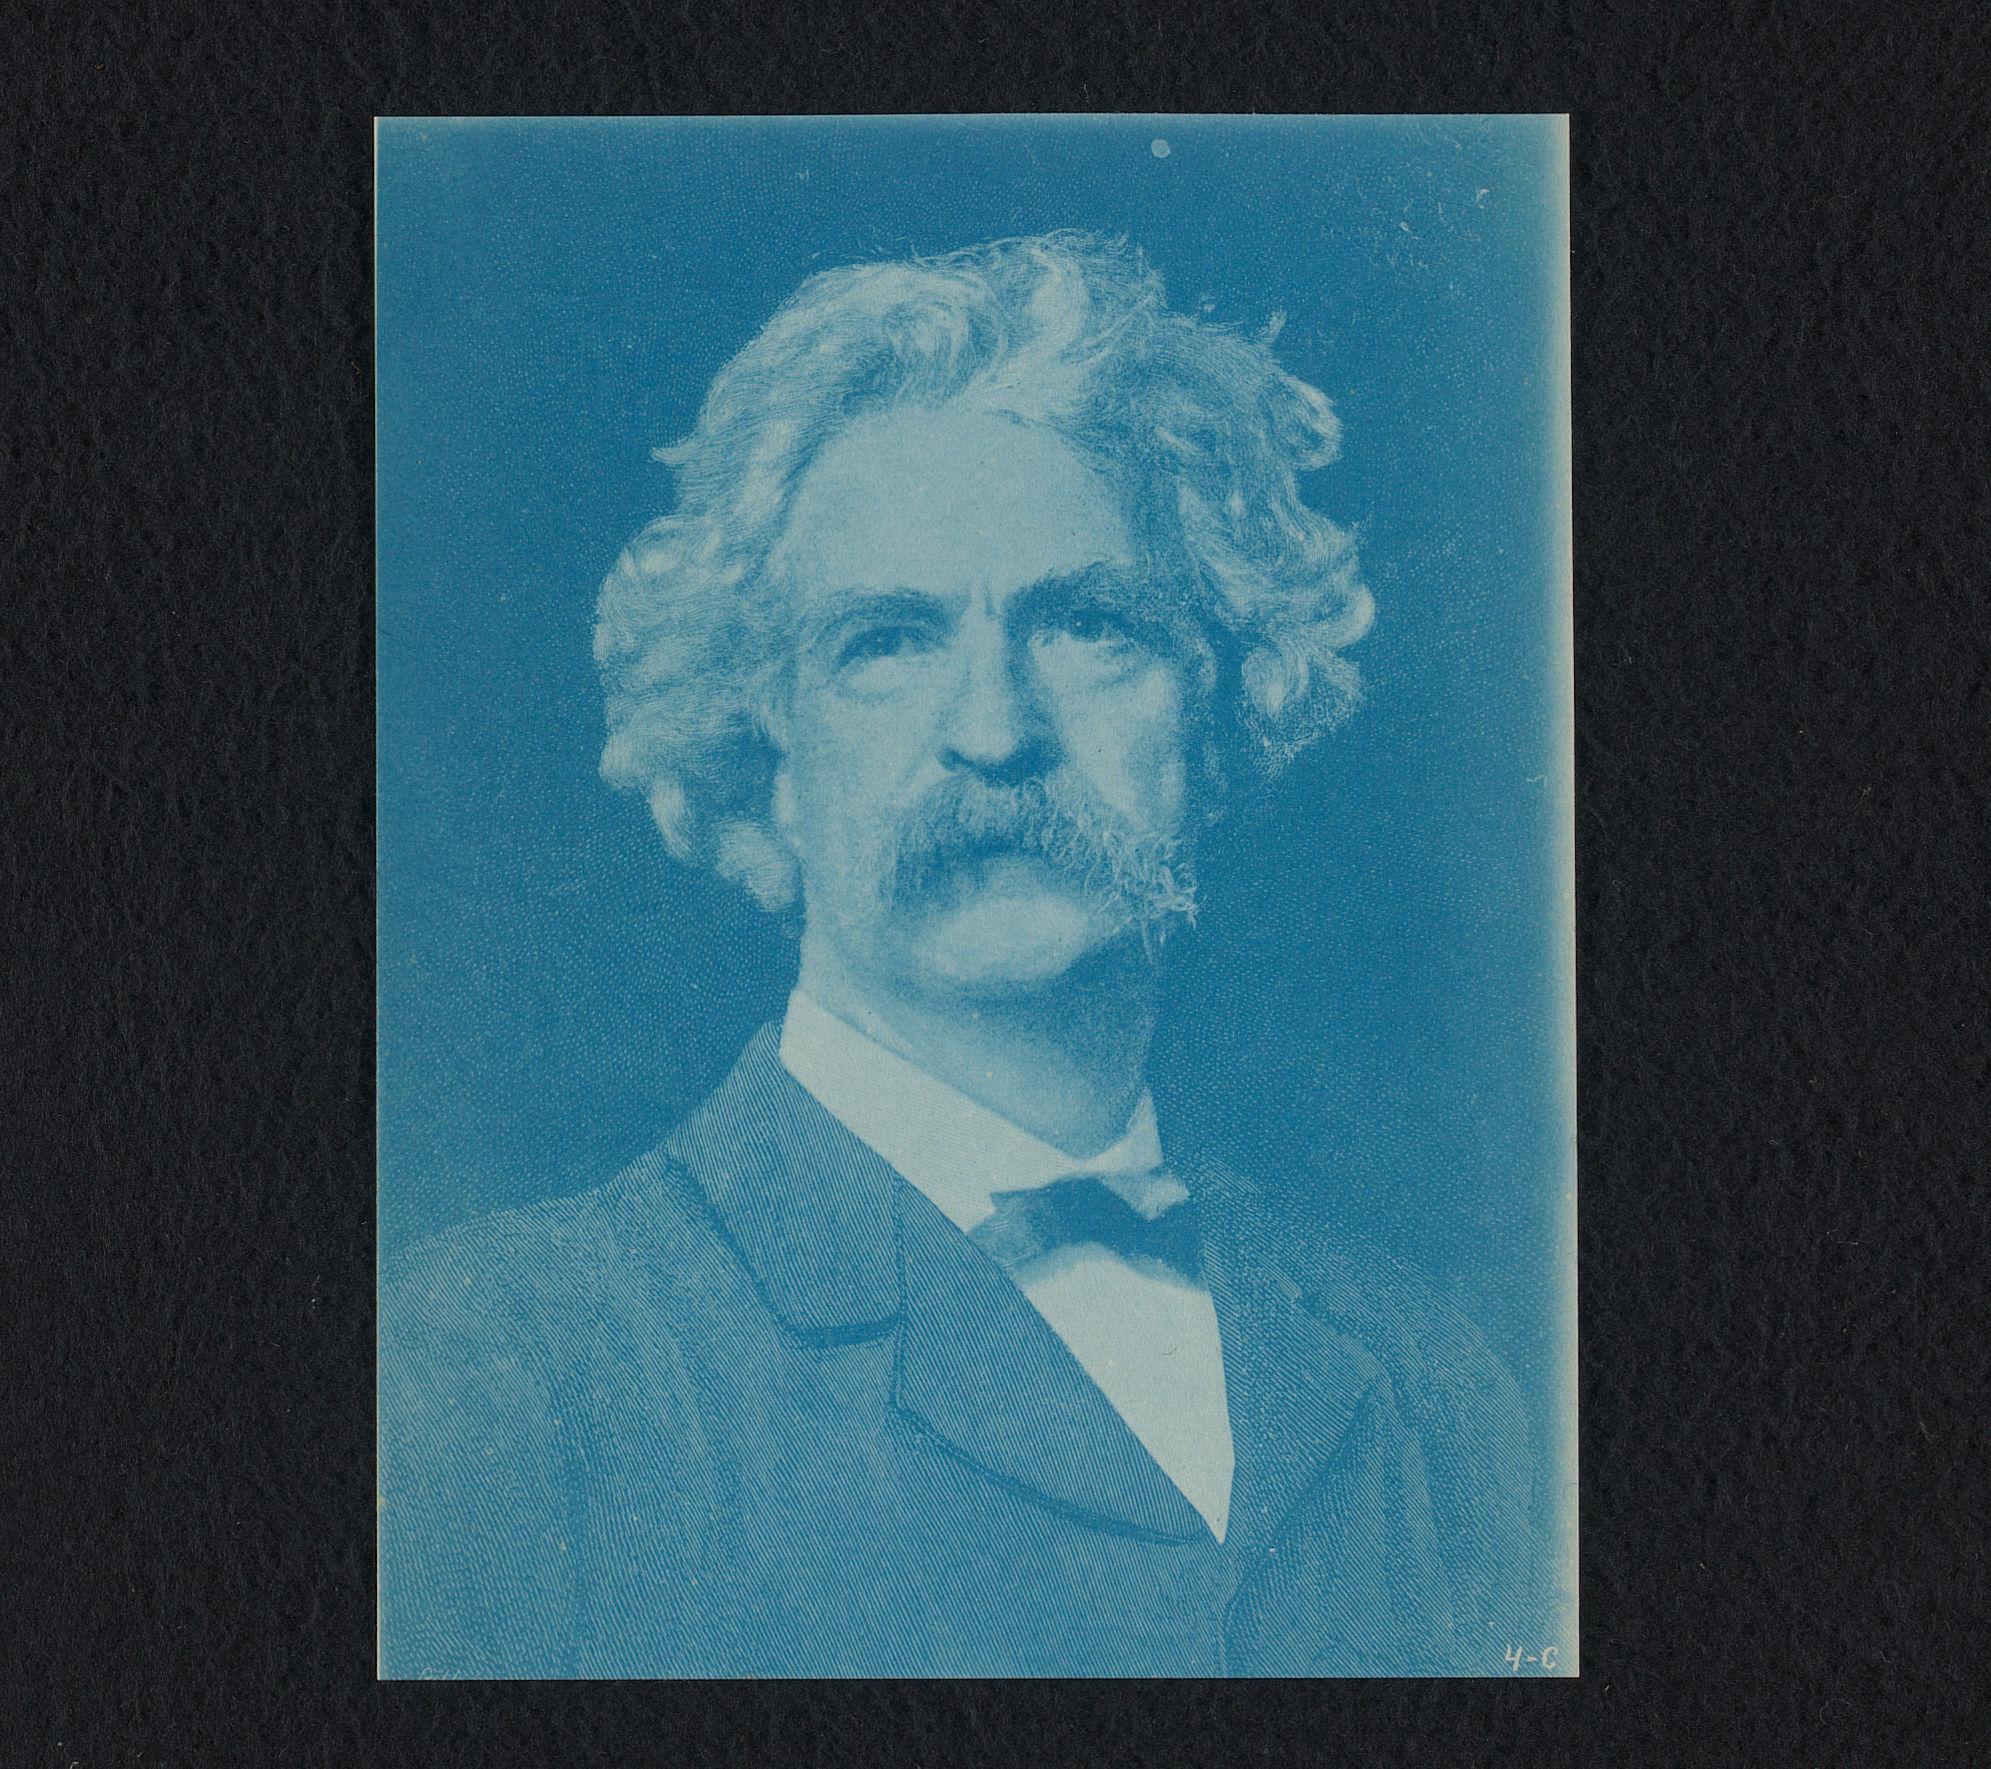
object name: reproduction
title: Fotoreproductie van een prent van een portret van Mark Twain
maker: Anonymous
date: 1890-1901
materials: paper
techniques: cyanotype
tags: historical persons, writer, poet, author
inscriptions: inscription: ‘Mark Twain’